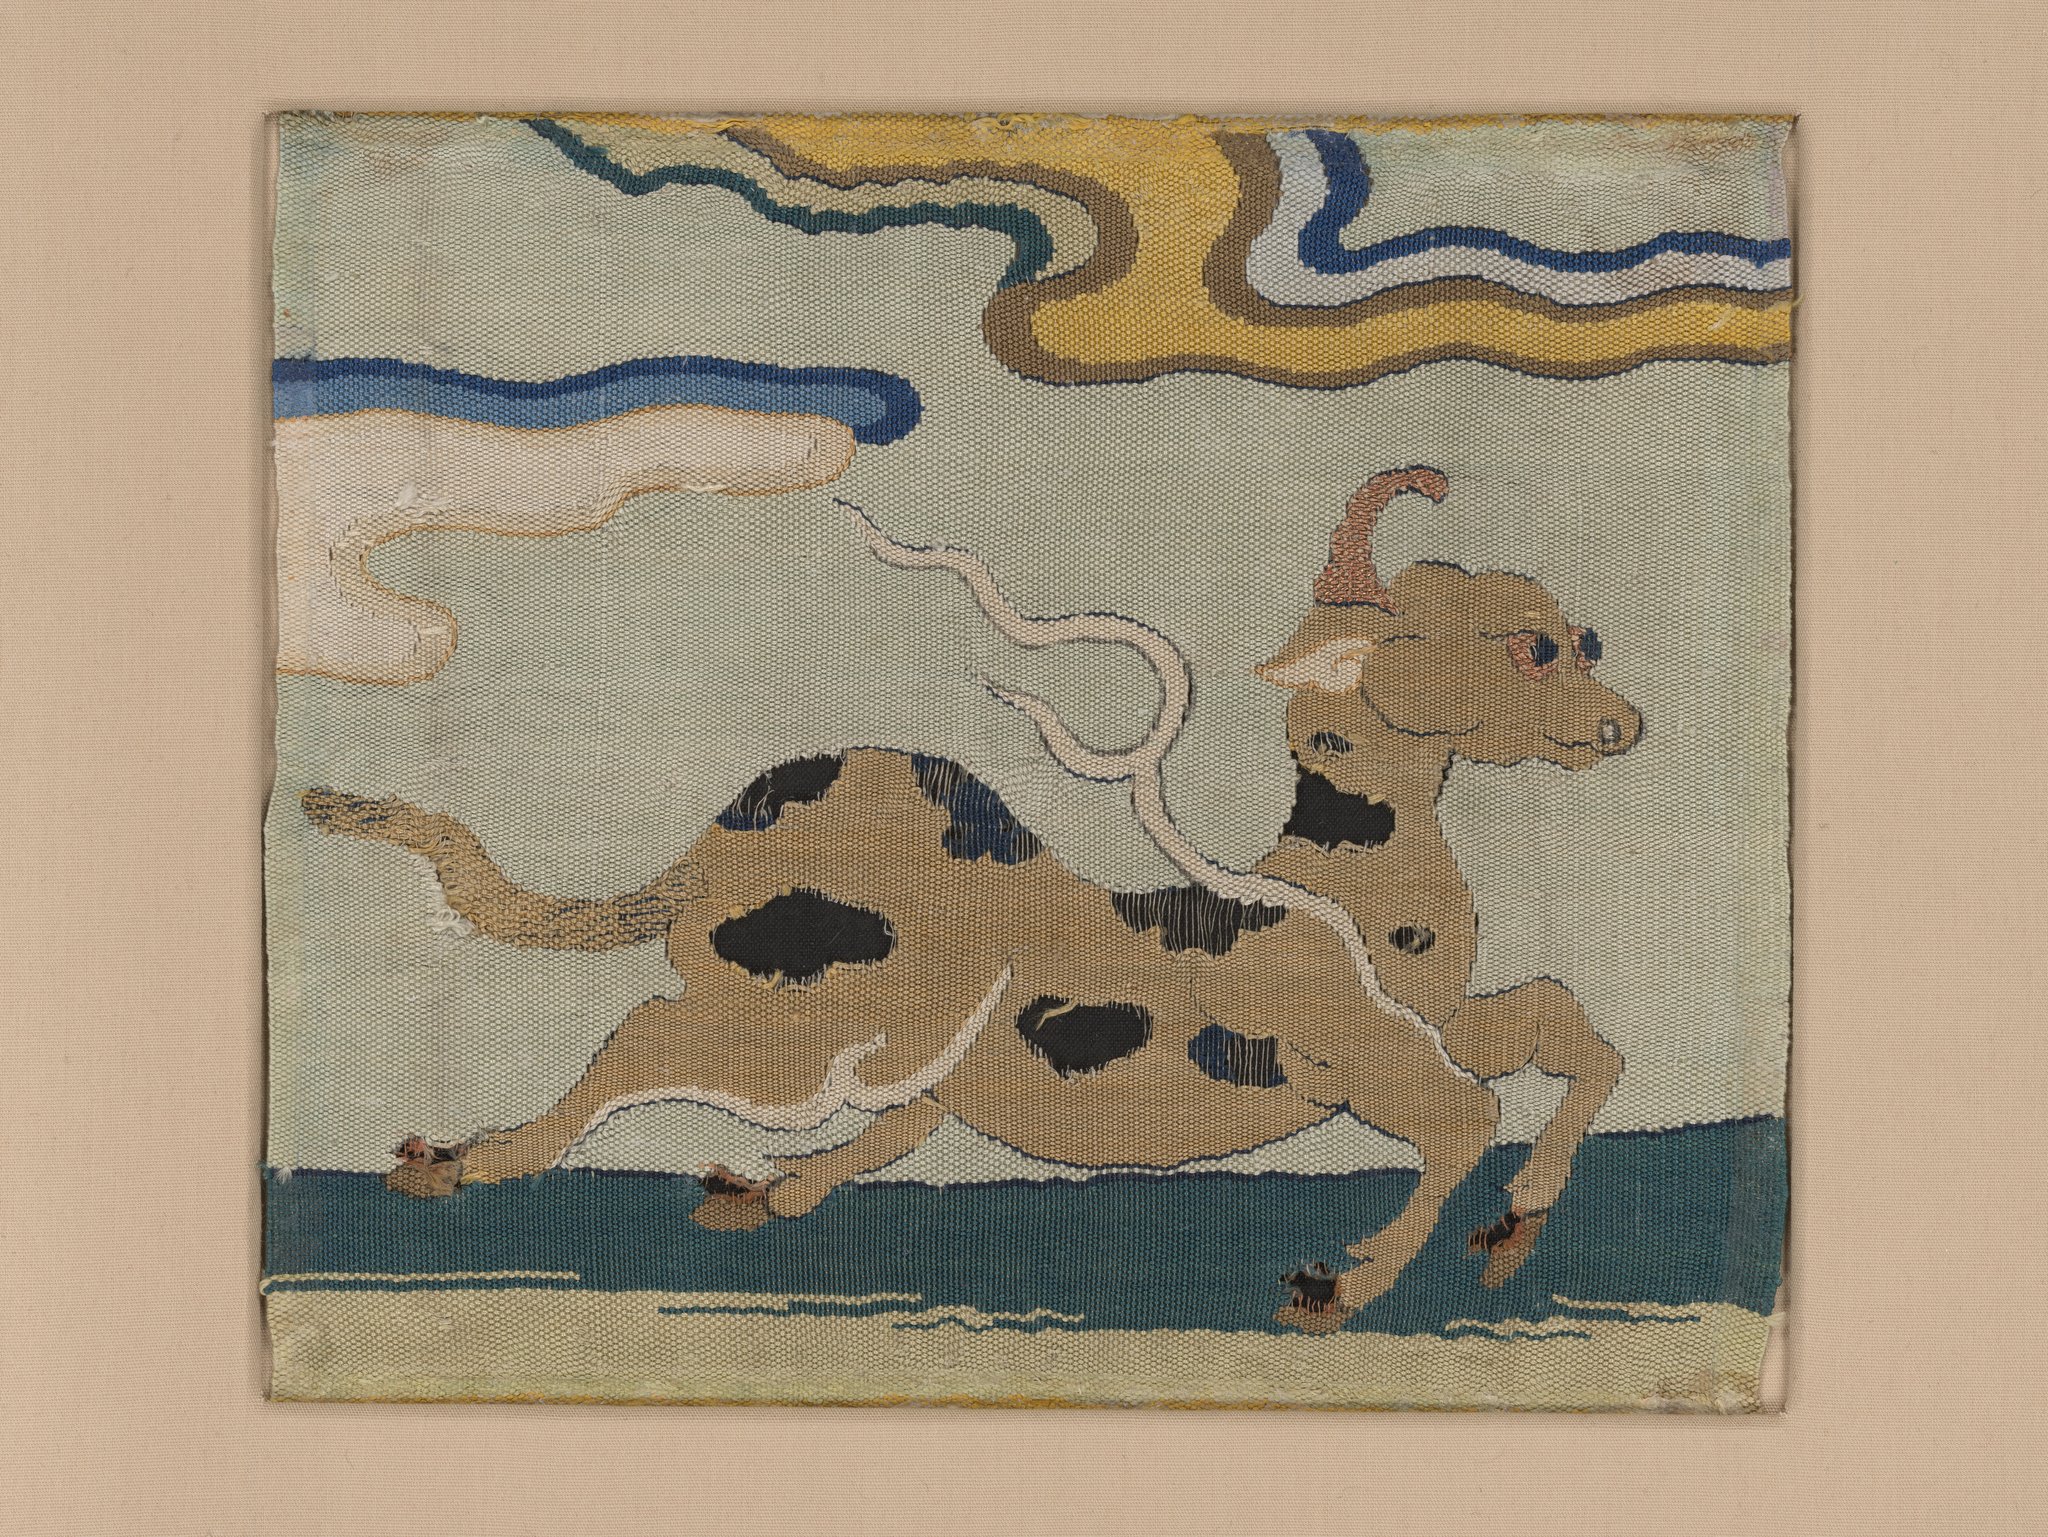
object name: square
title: Square with Fantastic Animal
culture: chinese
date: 1567-1633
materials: metal thread, silk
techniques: tapestry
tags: animals